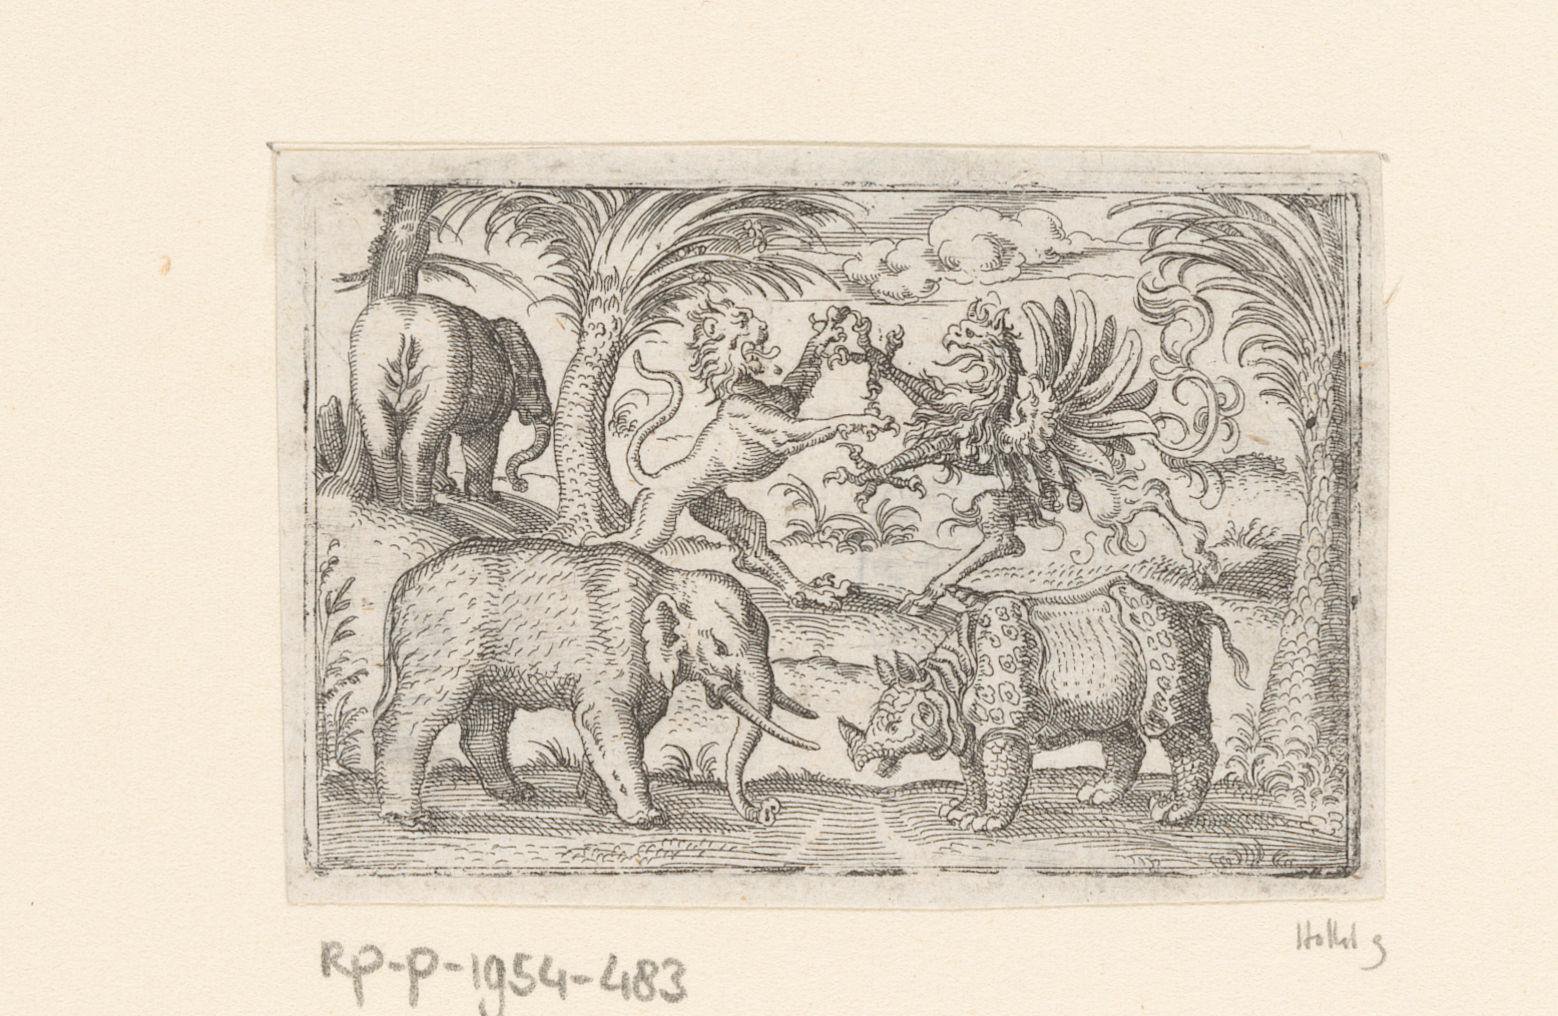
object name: print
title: Twee olifanten, een neushoorn, een leeuw en een griffioen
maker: stephan herman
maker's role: print maker, publisher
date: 1578-1596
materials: paper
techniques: etching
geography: ansbach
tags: griffin (lion/eagle); 'griffo' (ripa), hoofed animals: rhinoceros, beasts of prey, predatory animals: lion, trunked animals: elephant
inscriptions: collector's mark: Lugt 2228, collector's mark: Lugt 2760, collector's mark: Lugt 2542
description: Onderdeel van een serie van tien prenten van dieren.